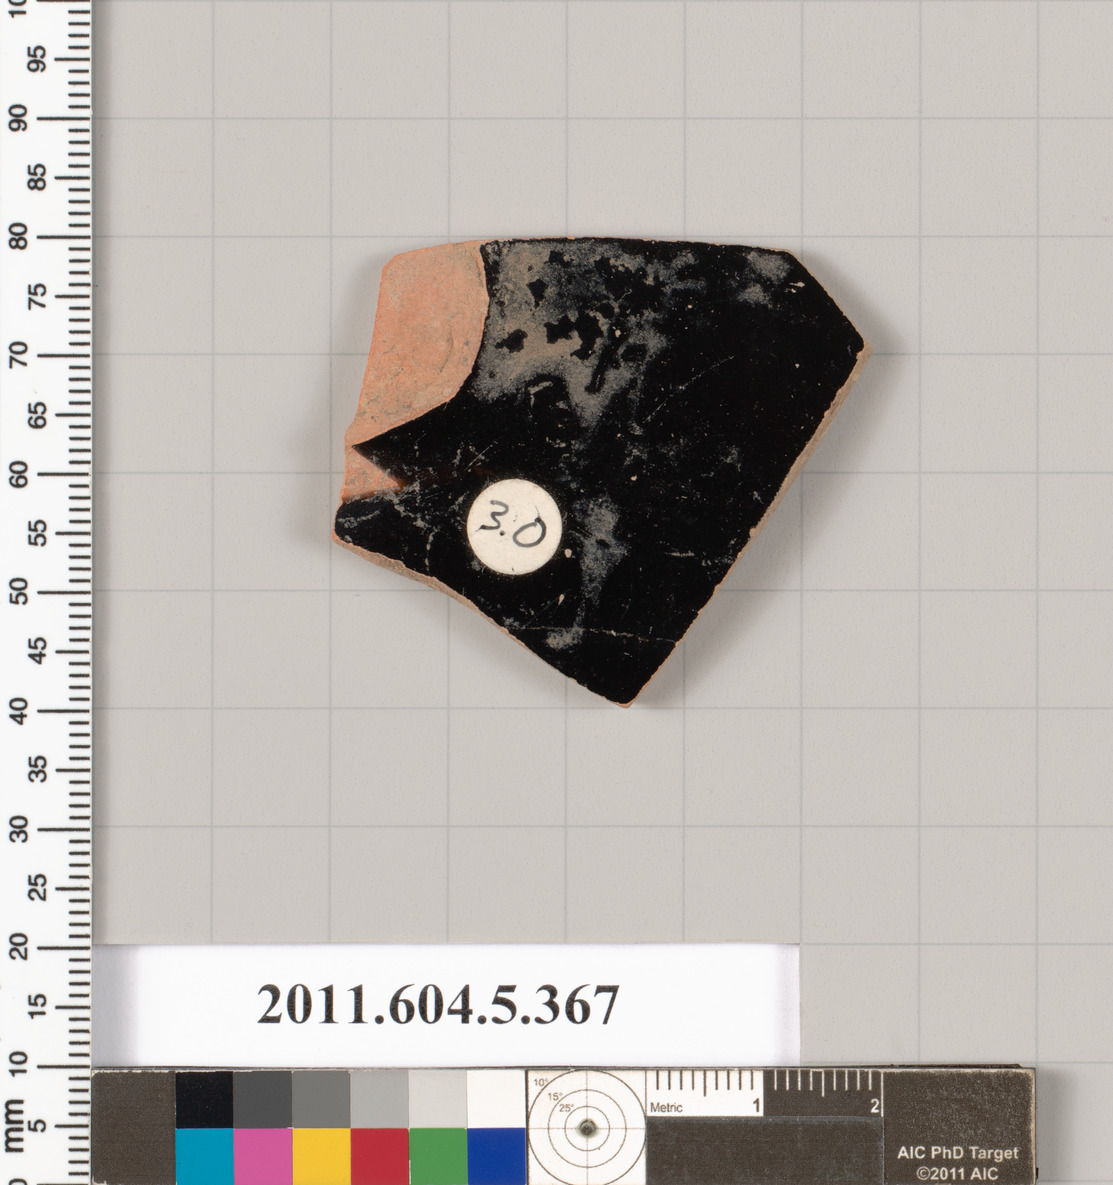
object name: kylix fragment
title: Terracotta fragment of a kylix (drinking cup)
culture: greek, attic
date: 600-401 BCE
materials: terracotta